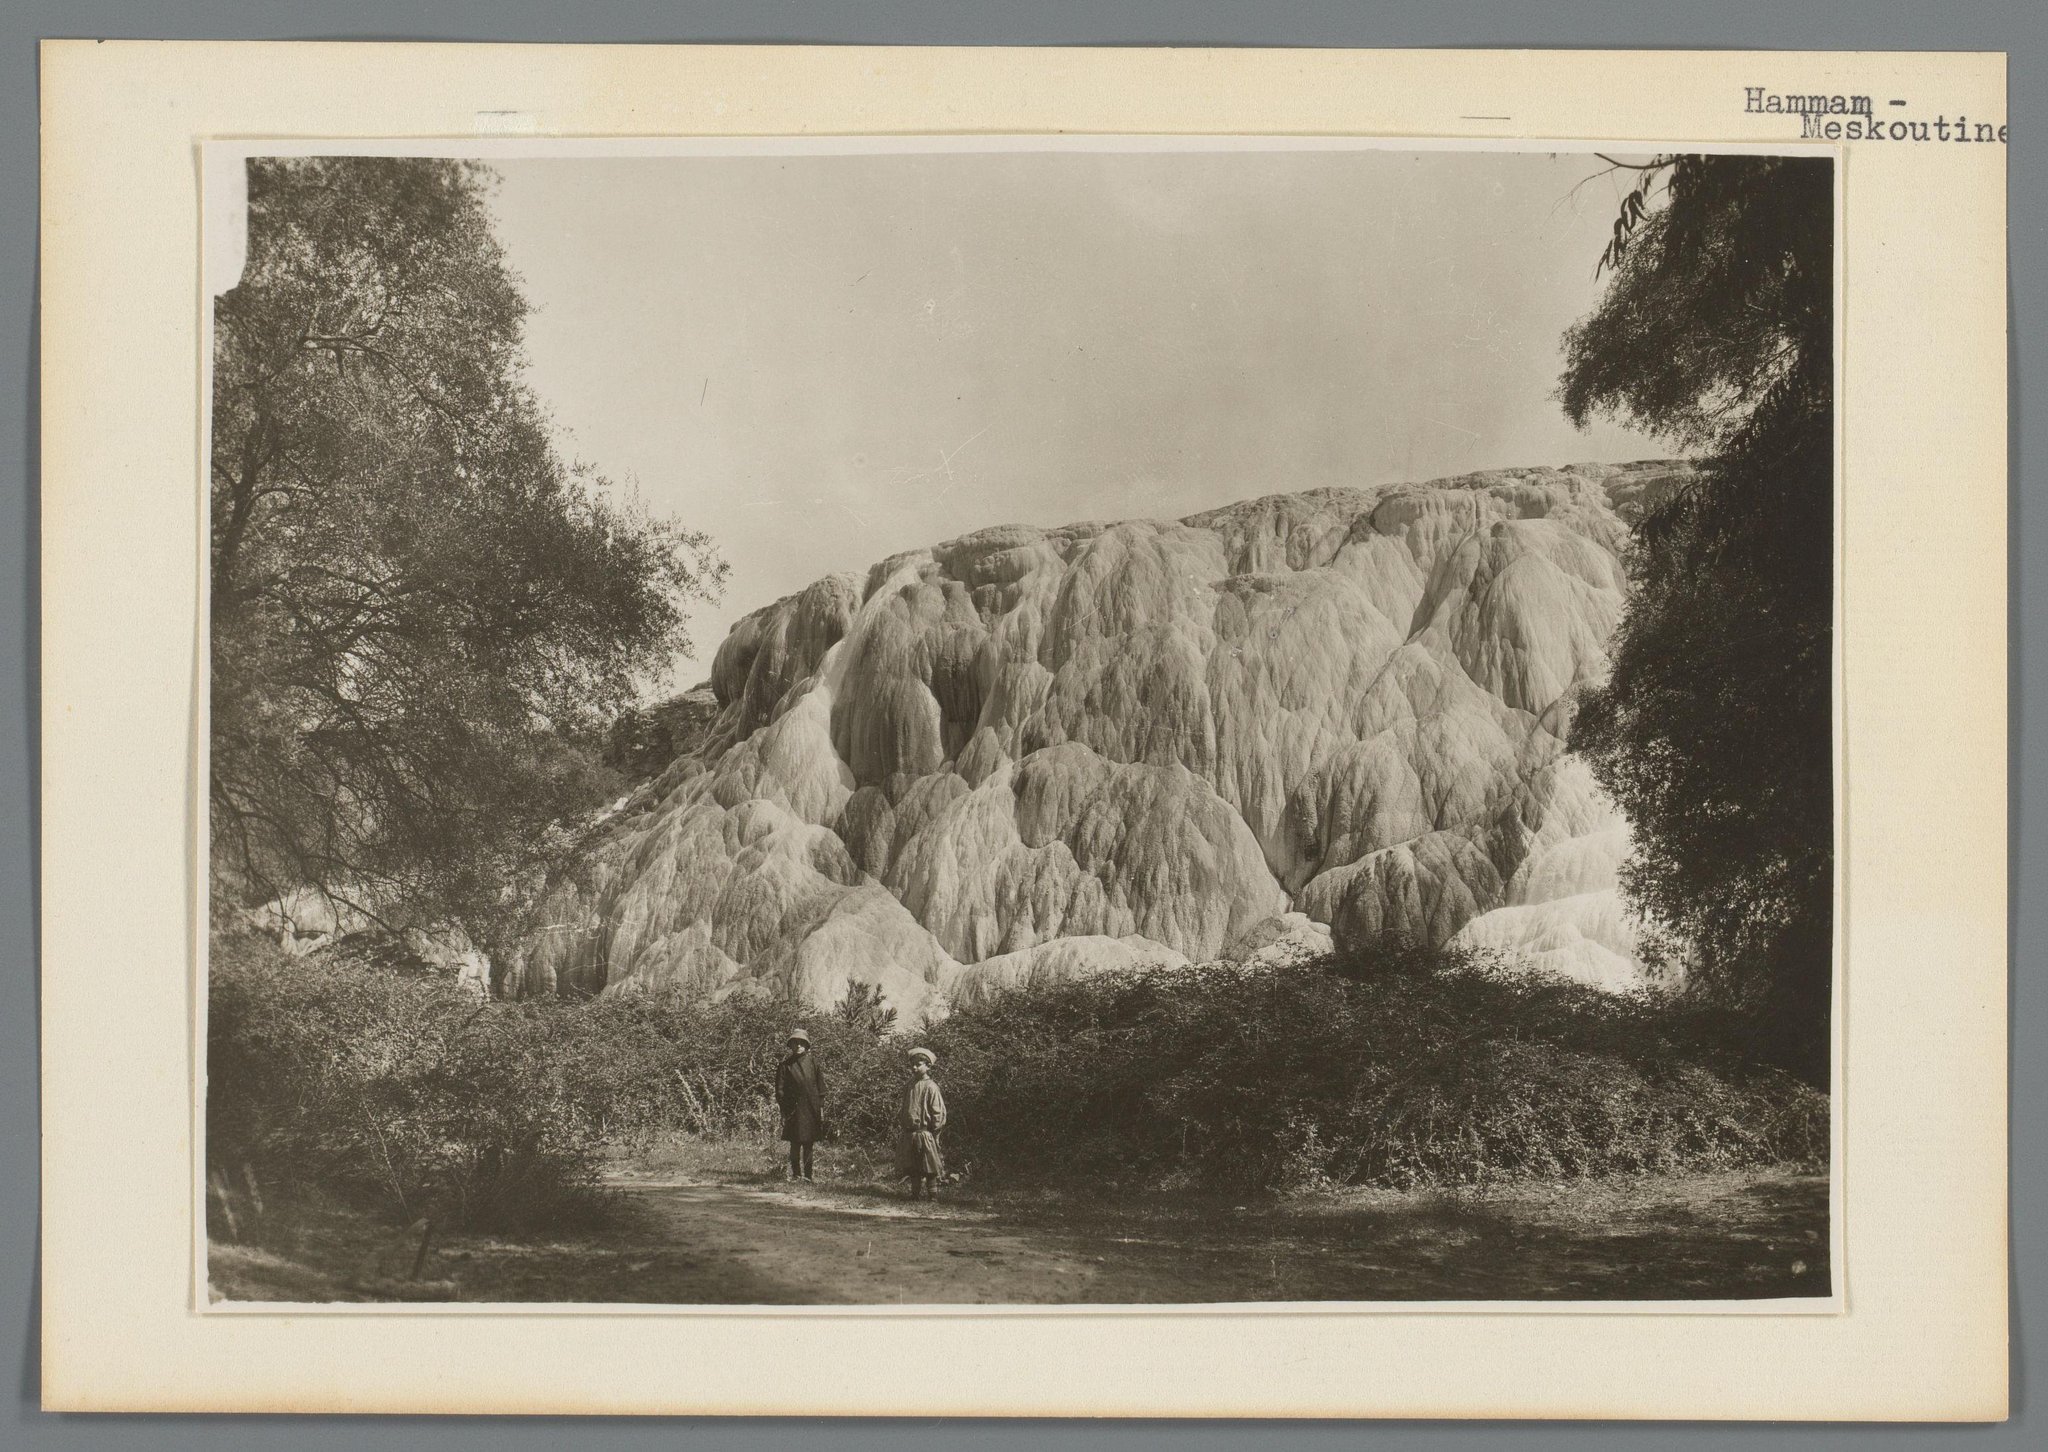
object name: photograph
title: Gezicht op de wanden van de thermische bron Hammam Meskhoutine, Algerije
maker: Anonymous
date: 1900-1930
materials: paper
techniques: gelatin silver print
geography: hammam debagh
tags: spring (fluids extracted from the earth)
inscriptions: number: ‘40.981’, number: ‘801000’, inscription: ‘Hammam Meskhoutine/ La Source’, inscription: ‘La Source’